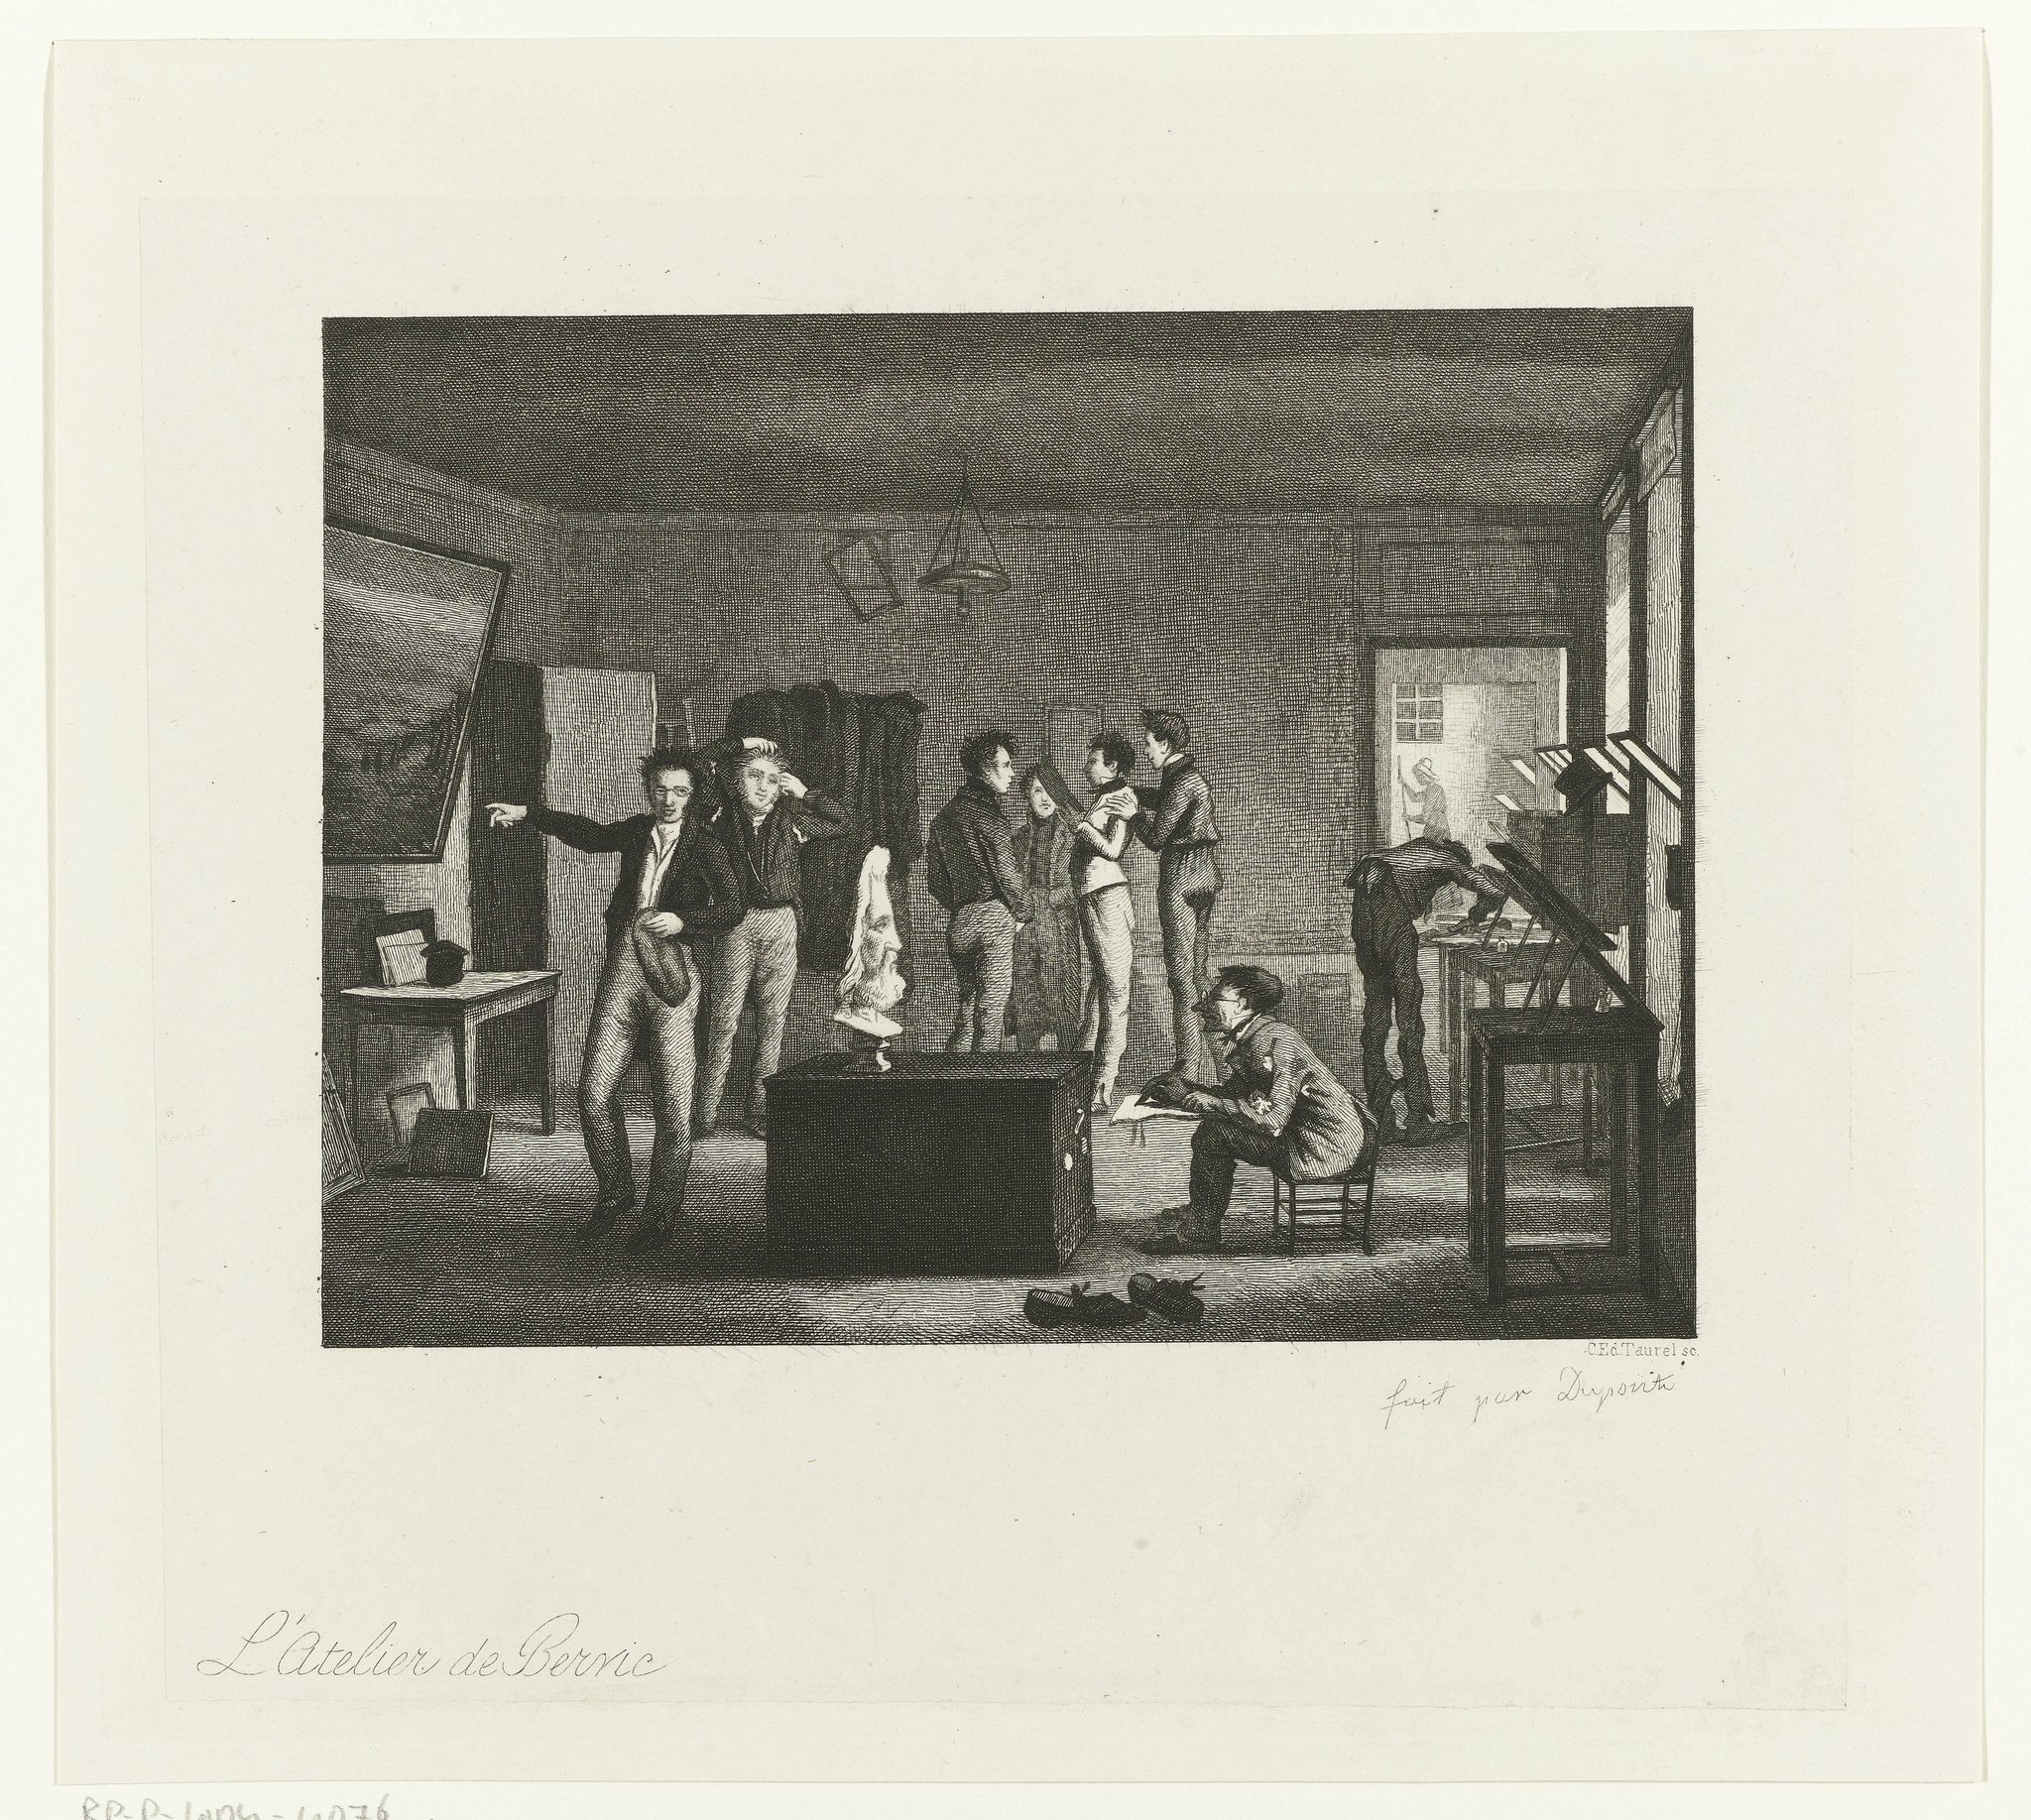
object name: print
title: L'Atelier de Bervic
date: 1885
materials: paper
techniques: engraving, etching, roulette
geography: amsterdam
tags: artist at work, in his workshop, workshop, studio of the artist (in general), artist (in general)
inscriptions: collector's mark: Lugt 2228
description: Prent ook gebruikt als illustratie in: L'album T. douze eaux-fortes d'après des dessins originaux et inédits de Jean Alaux, Léon Cogniet, Coutan, Henriquel Dupont, Ingres, Léopold Robert et Etna Michalon avec texte explicatif et biographique enrichi de lettres inédites. Amsterdam en Den Haag: 1885.